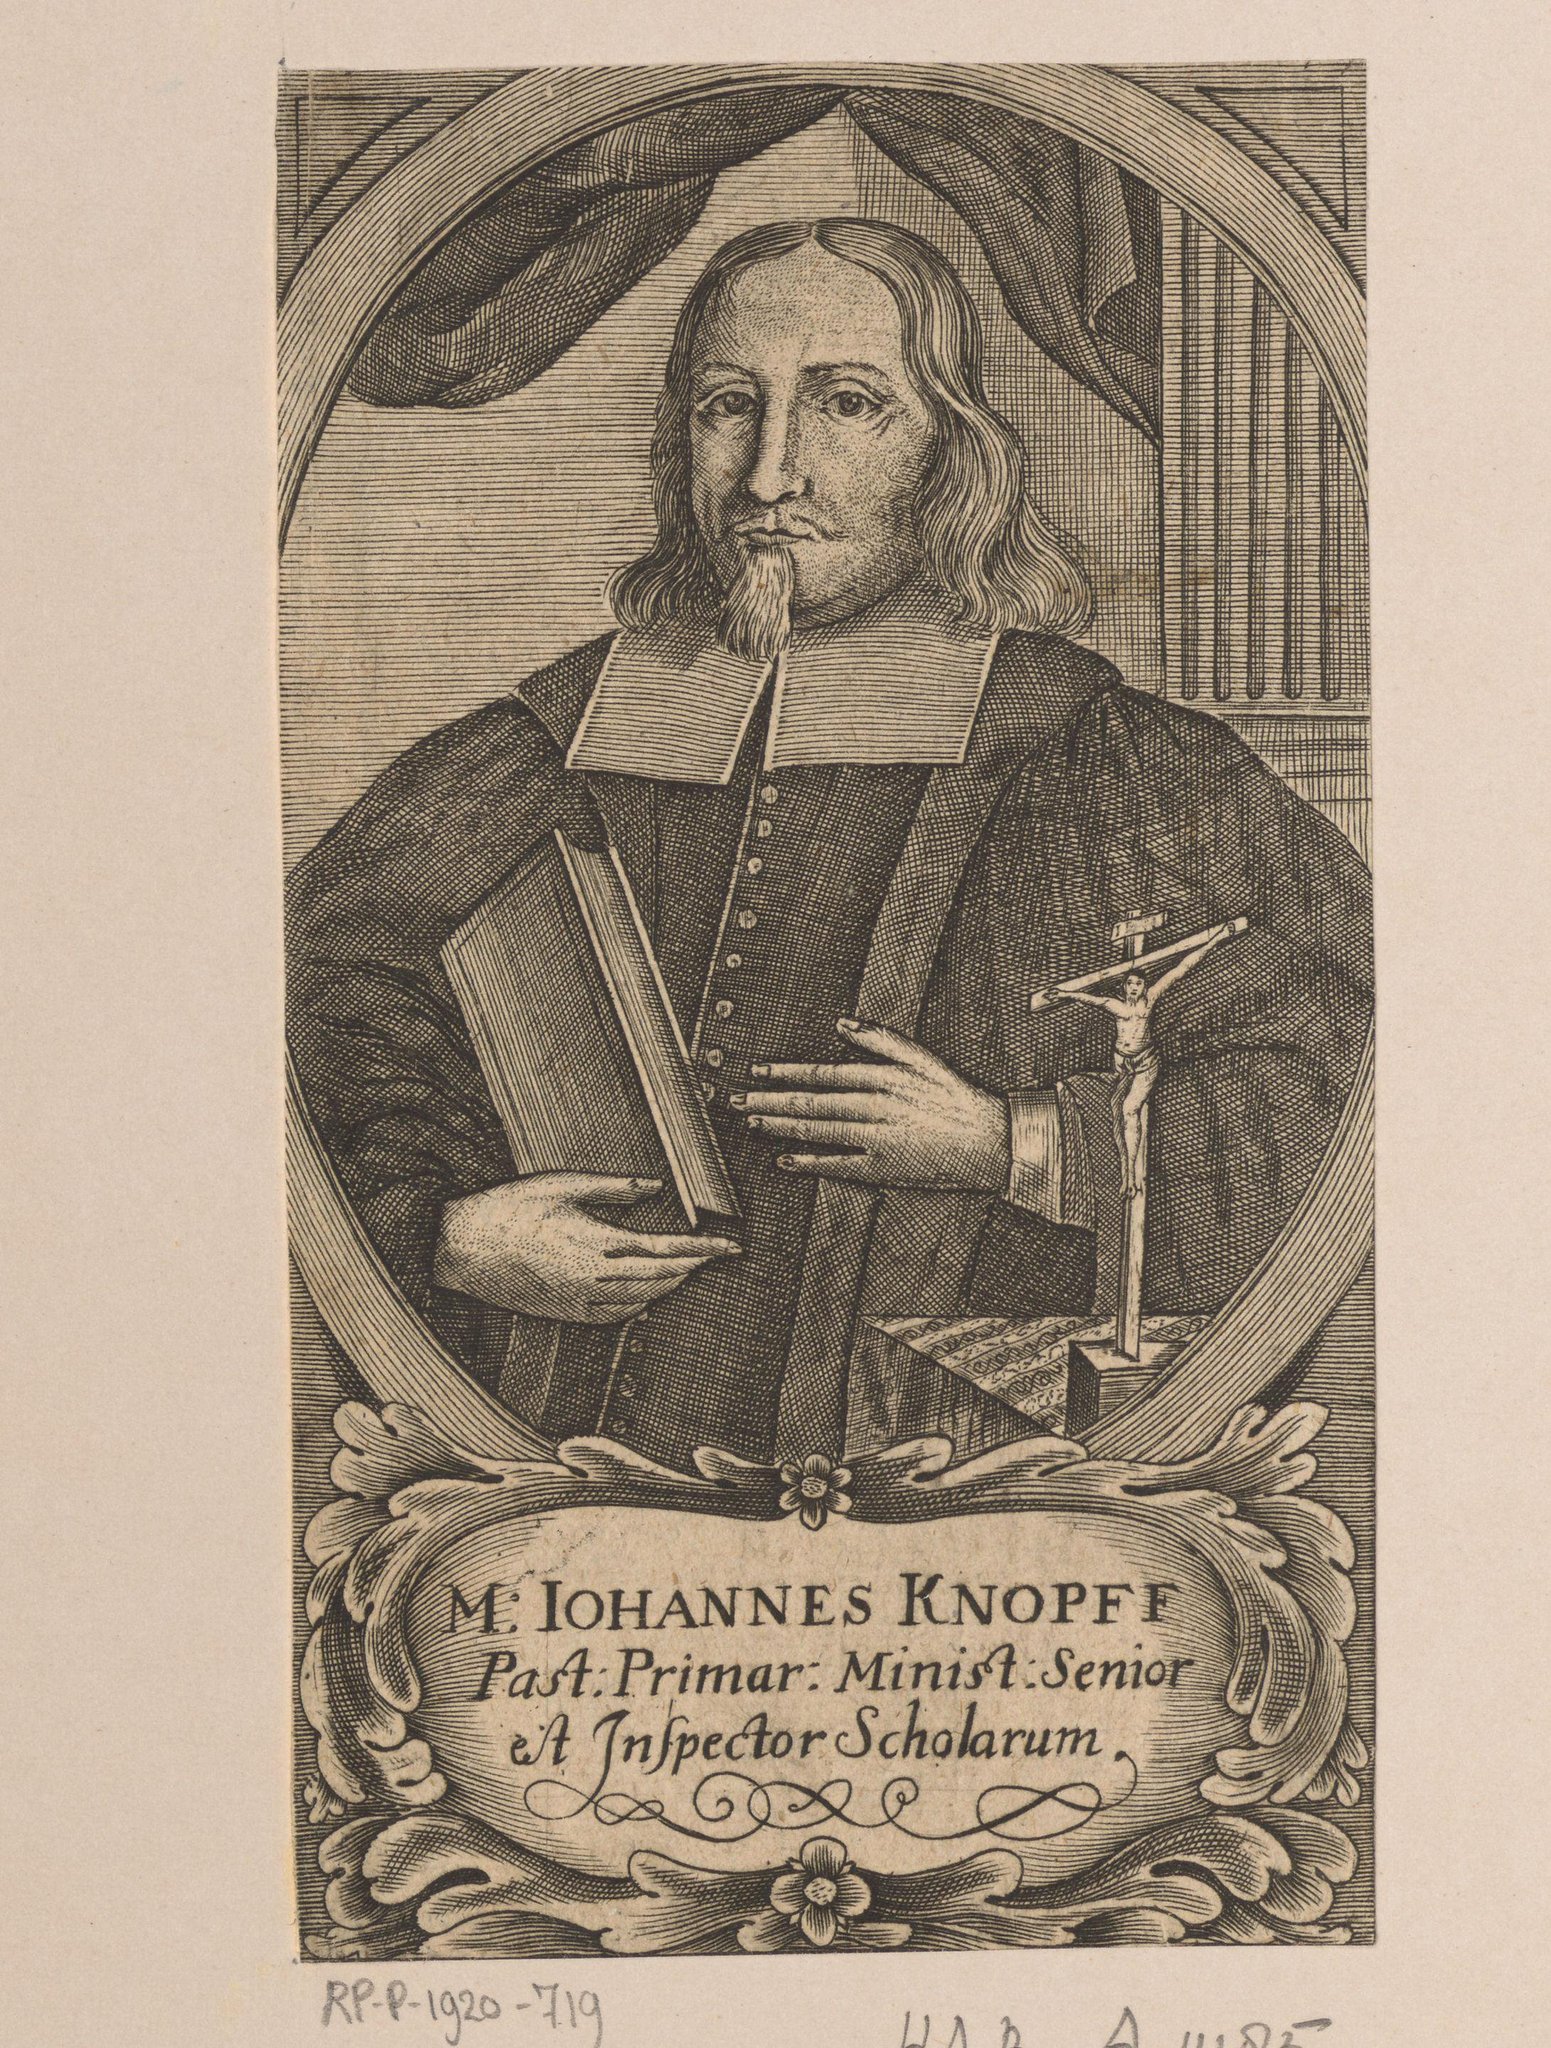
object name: print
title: Portret van Johan Knopff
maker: Anonymous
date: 1600-1666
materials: paper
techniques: engraving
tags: historical persons, book, cross with symbol of christ on it, e.g. lamb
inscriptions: collector's mark: Lugt 2228